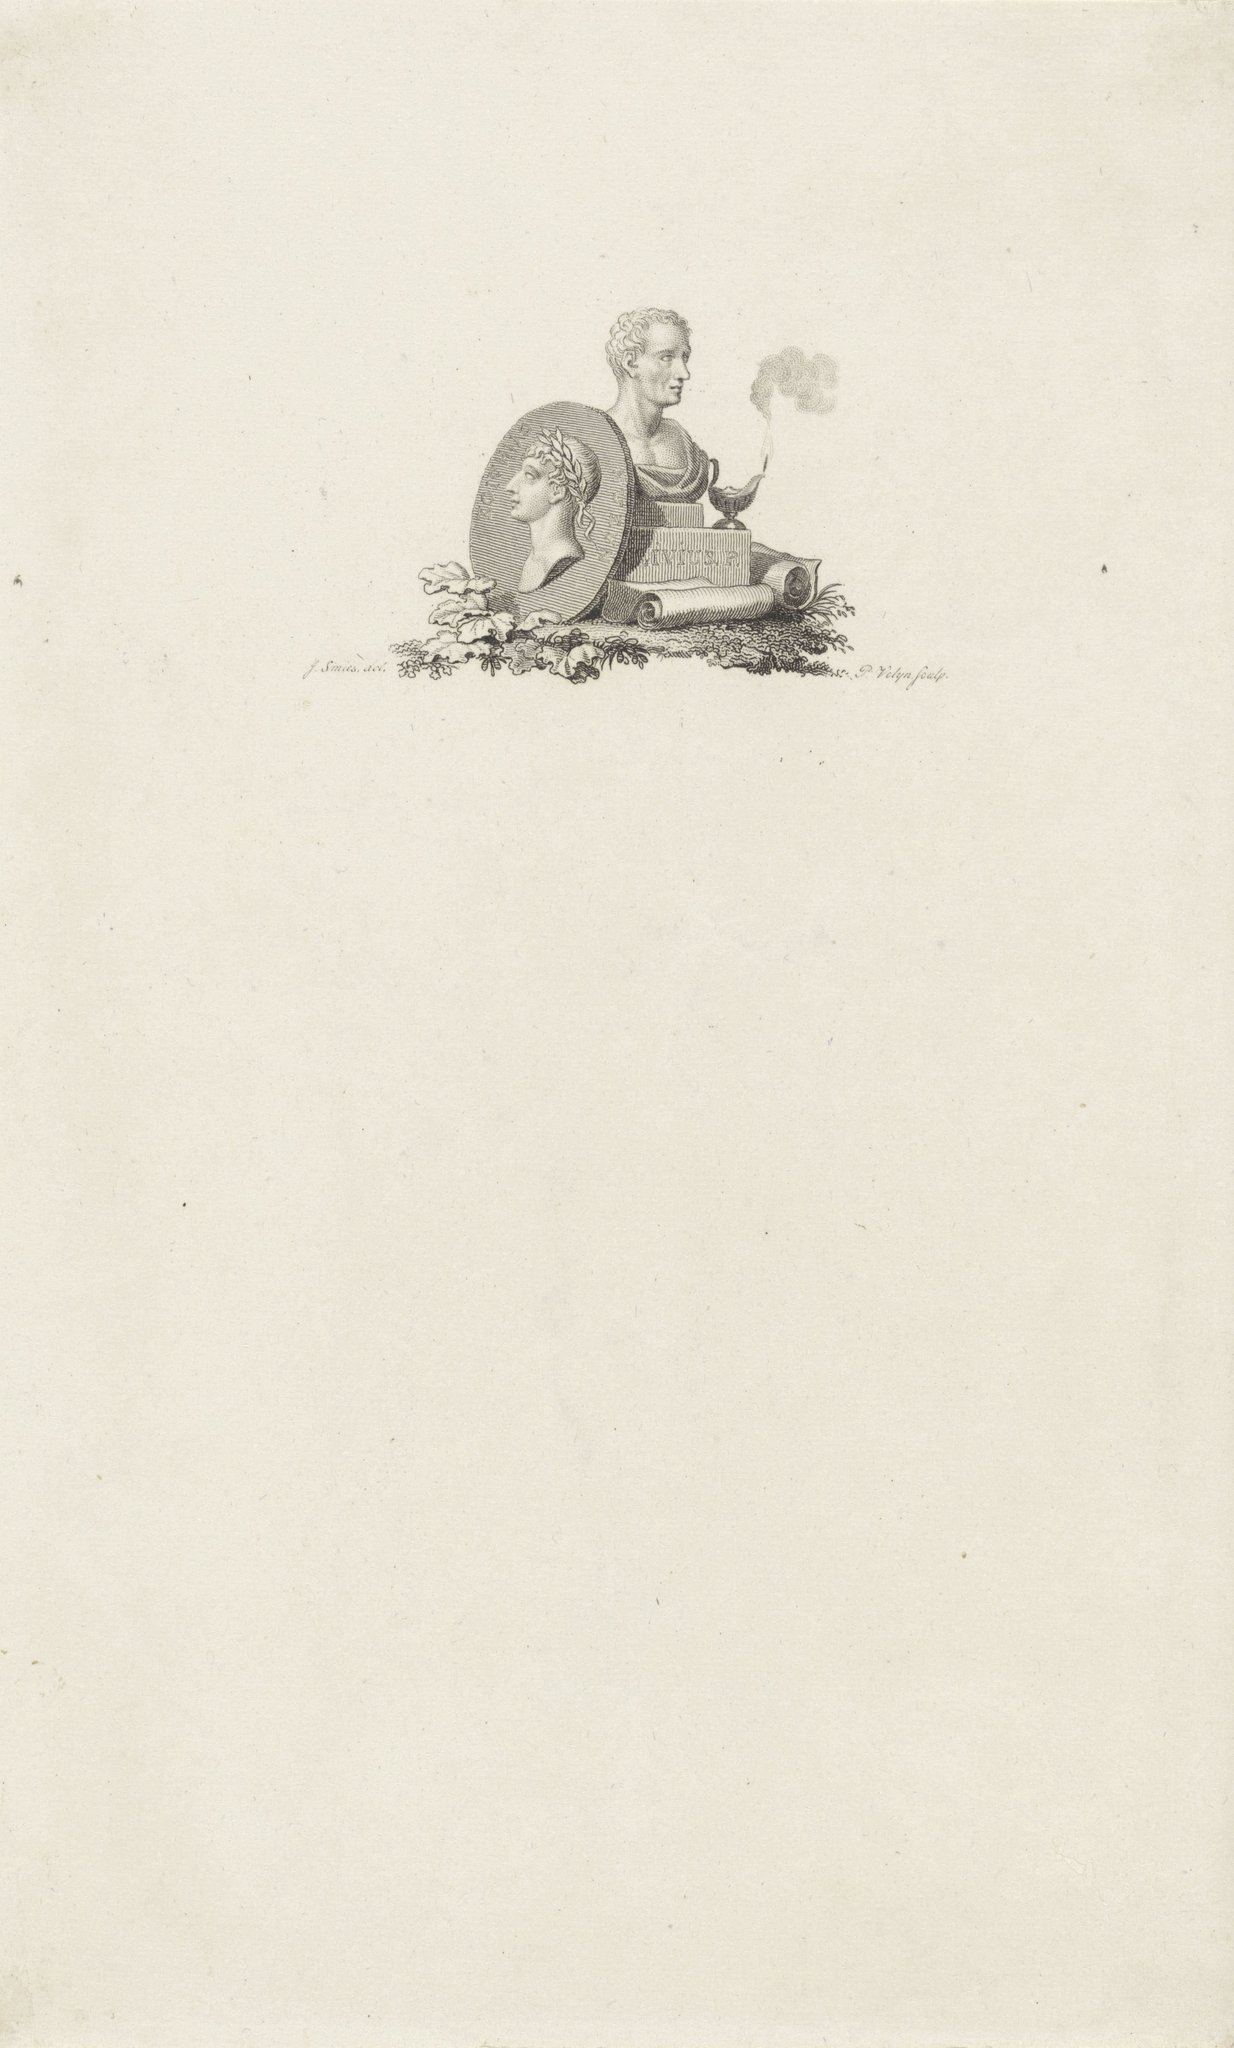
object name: print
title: Romeinse buste met olielamp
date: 1797-1836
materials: paper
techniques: etching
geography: netherlands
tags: oil-lamp, piece of sculpture, reproduction of a piece of sculpture, paper (writing material)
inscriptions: collector's mark: Lugt 2228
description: Een romeinse buste op een sokkel. Tegen de buste rust een ovaal met een Romeinse buste met lauwerkrans. Op de grond twee rollen papier en op de sokkel een brandende olielamp.